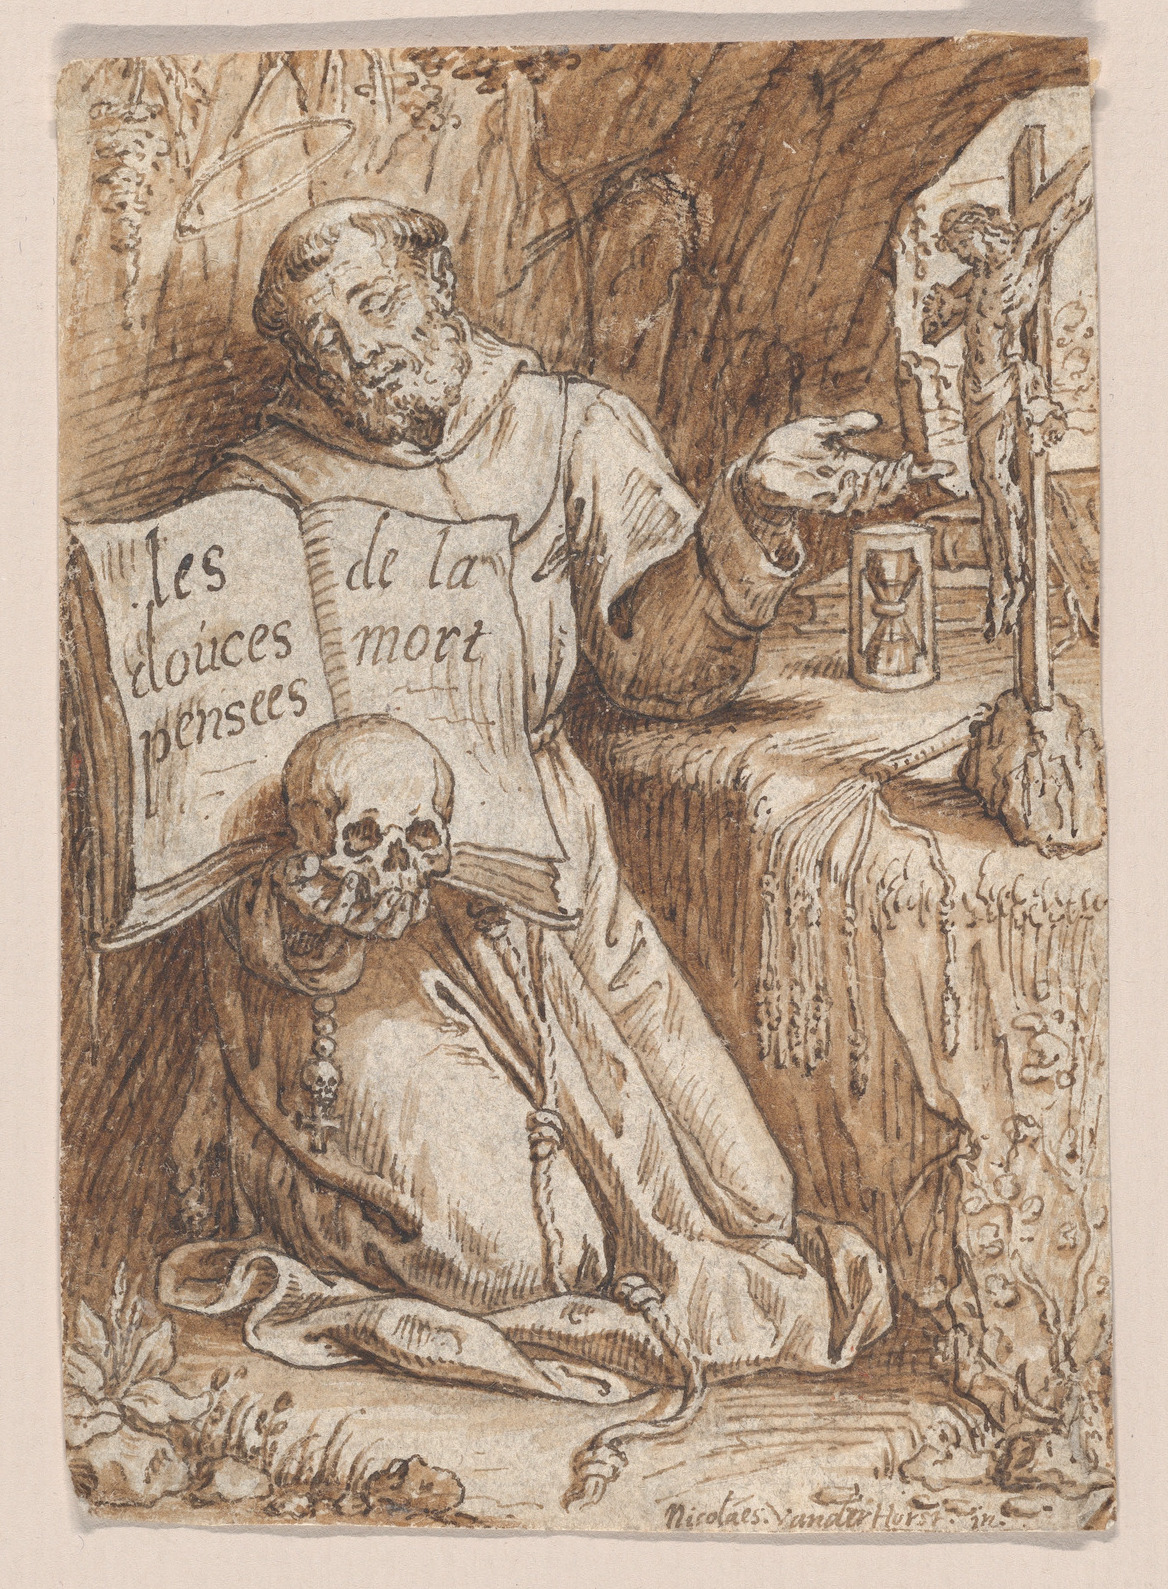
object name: drawing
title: Saint Francis Kneeling in a Grotto, holding a Book and a Skull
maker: nicolaas van der horst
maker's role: artist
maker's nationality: flemish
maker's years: 1587-1646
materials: ink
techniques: incising, pen, transfer, wash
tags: skulls,christ,saint francis,cross